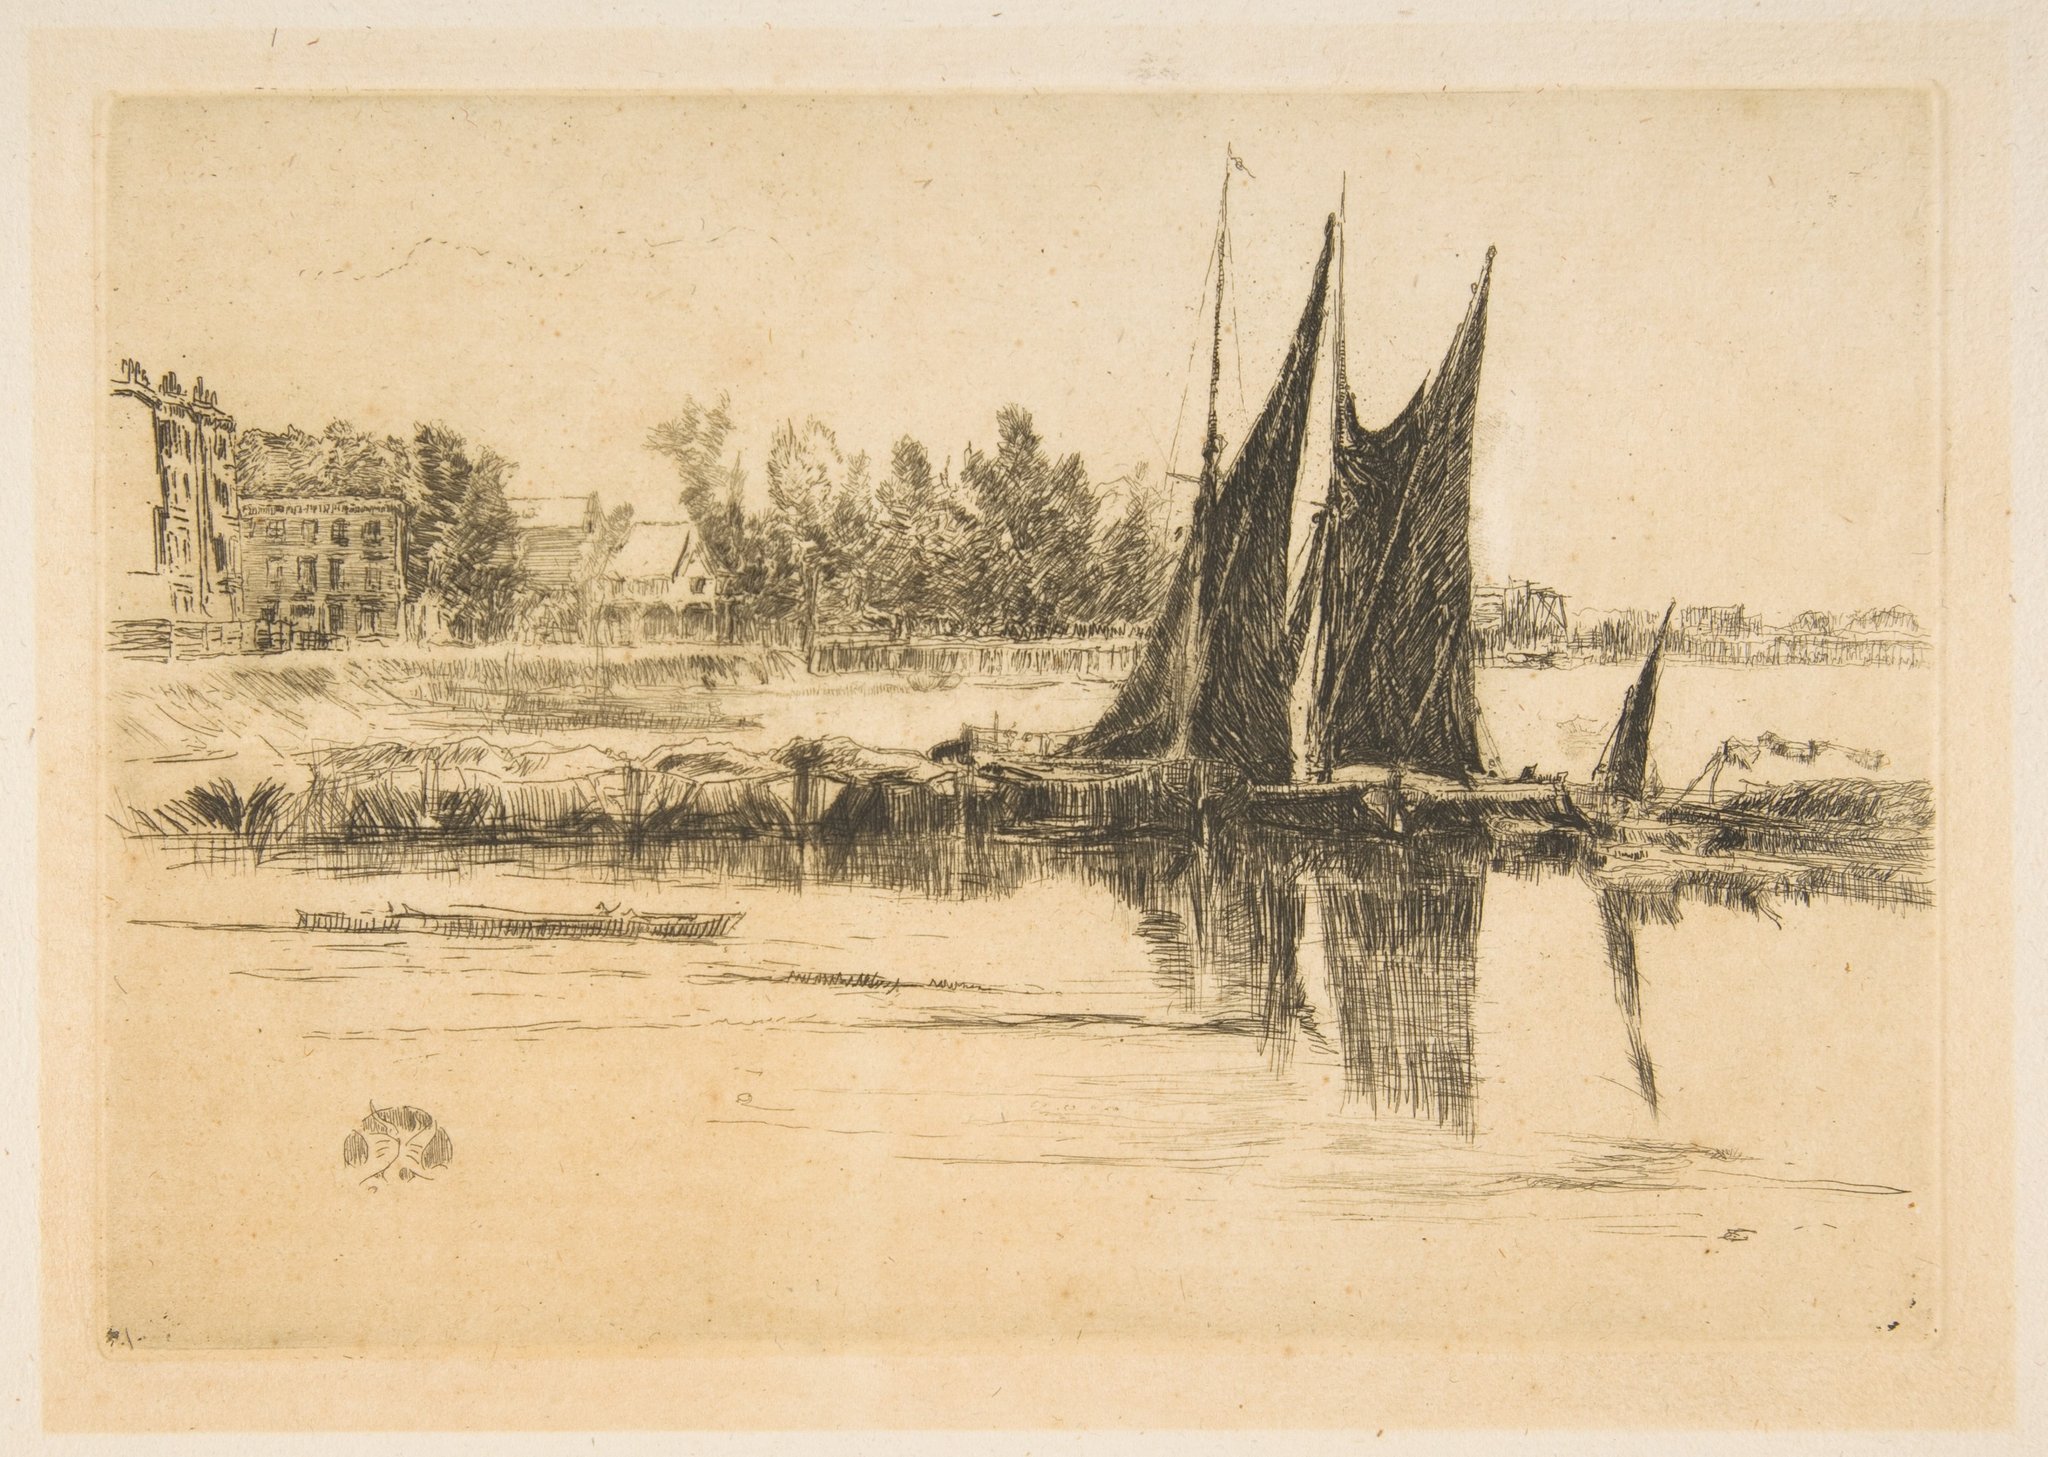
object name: print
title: Hurlingham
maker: james mcneill whistler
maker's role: artist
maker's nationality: american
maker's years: 1834-1903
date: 1879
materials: ink, paper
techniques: drypoint, etching, printing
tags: boats